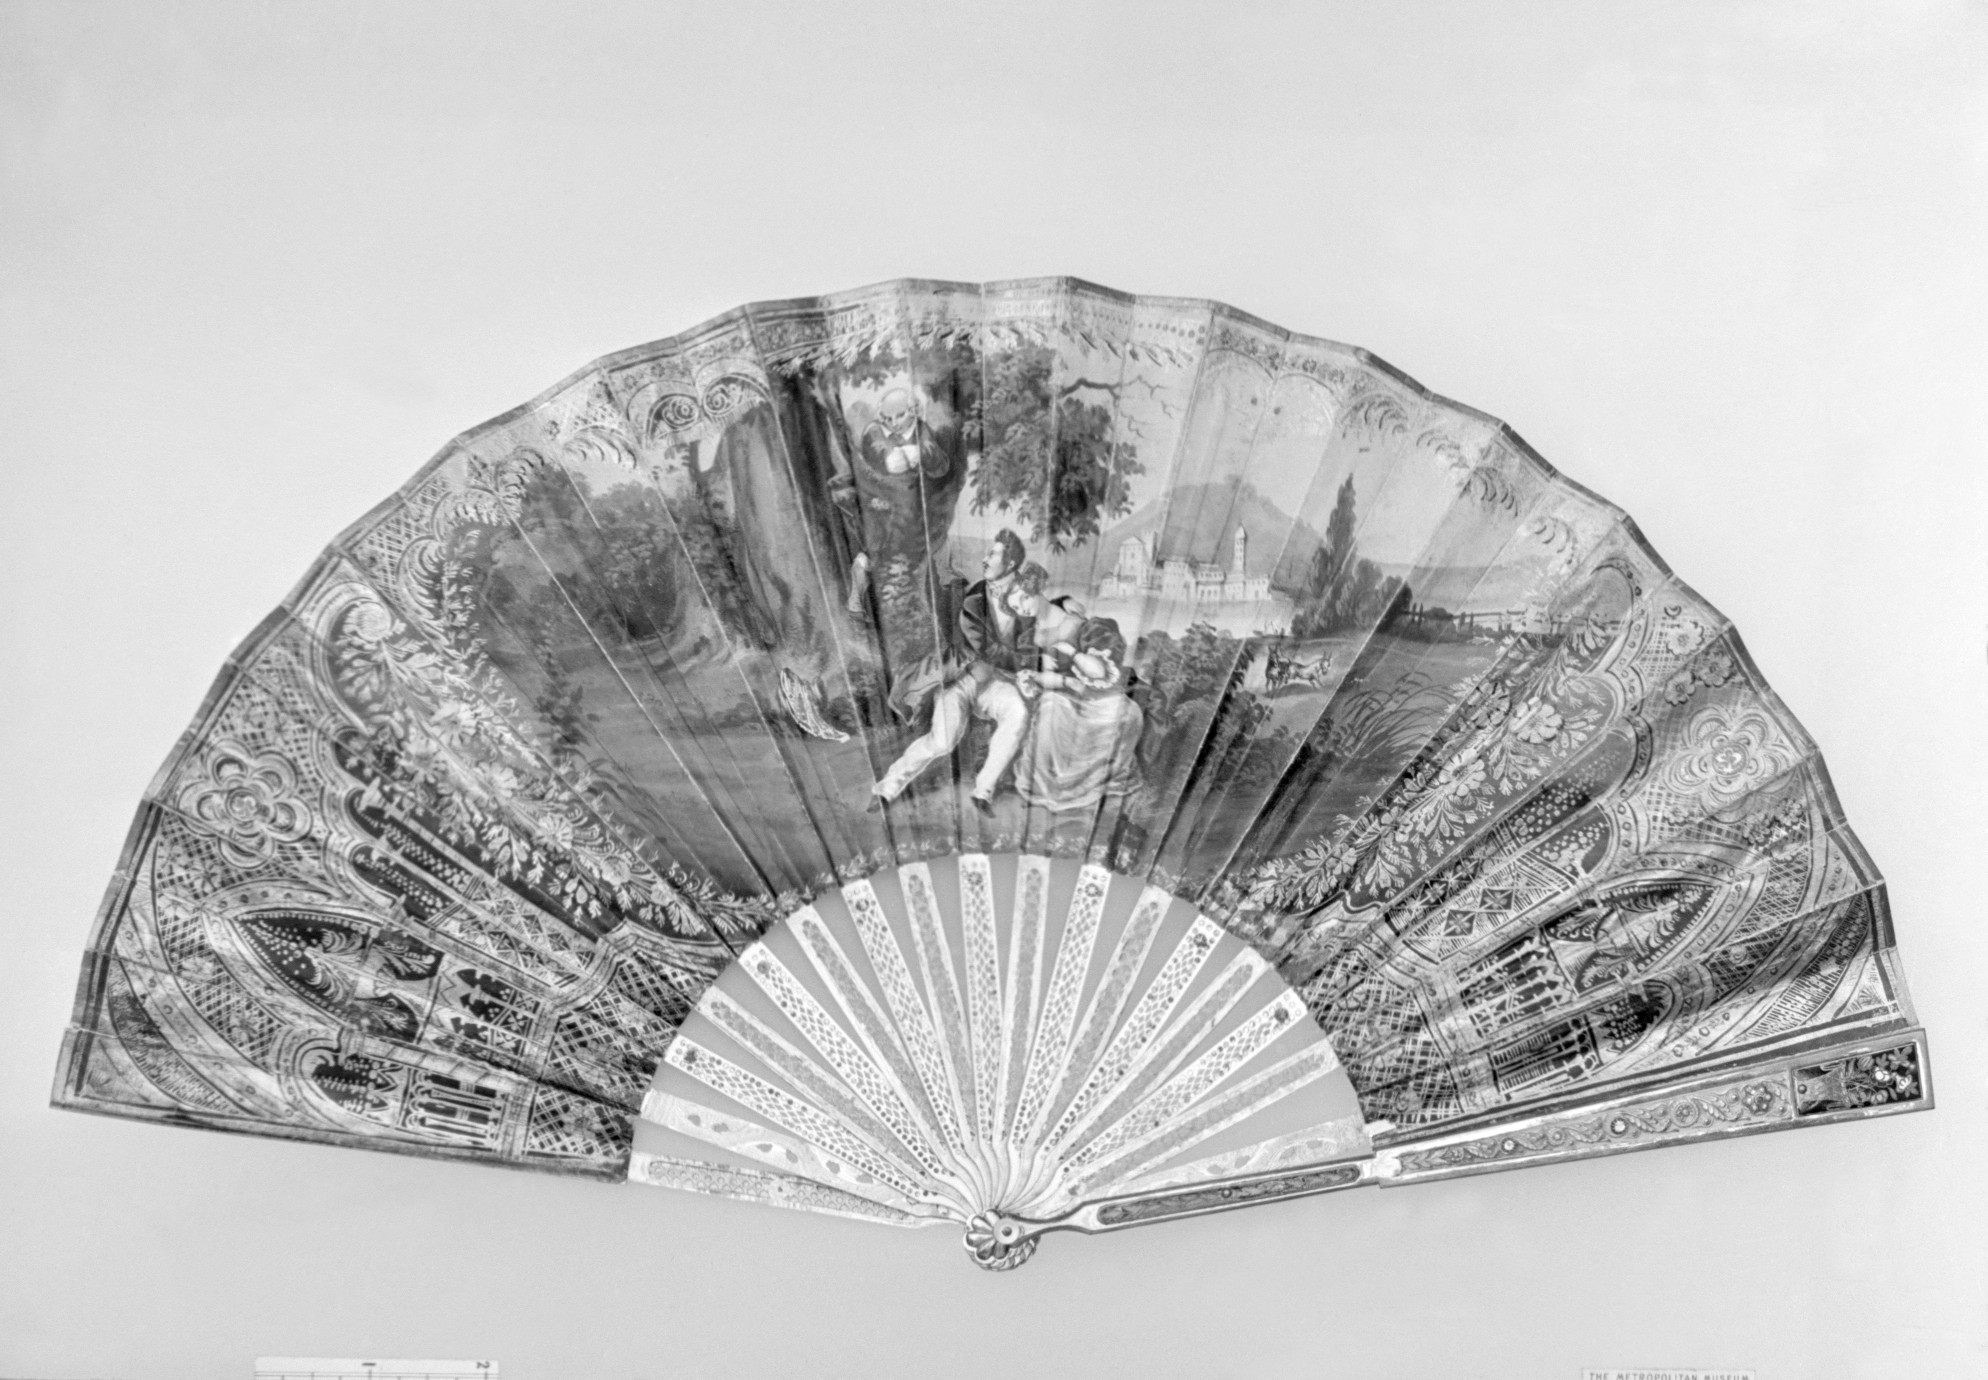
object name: fan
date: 1830-1840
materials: copper, gilt bronze, glass, mother of pearl, paper, pearl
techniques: enamel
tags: couples,men,women